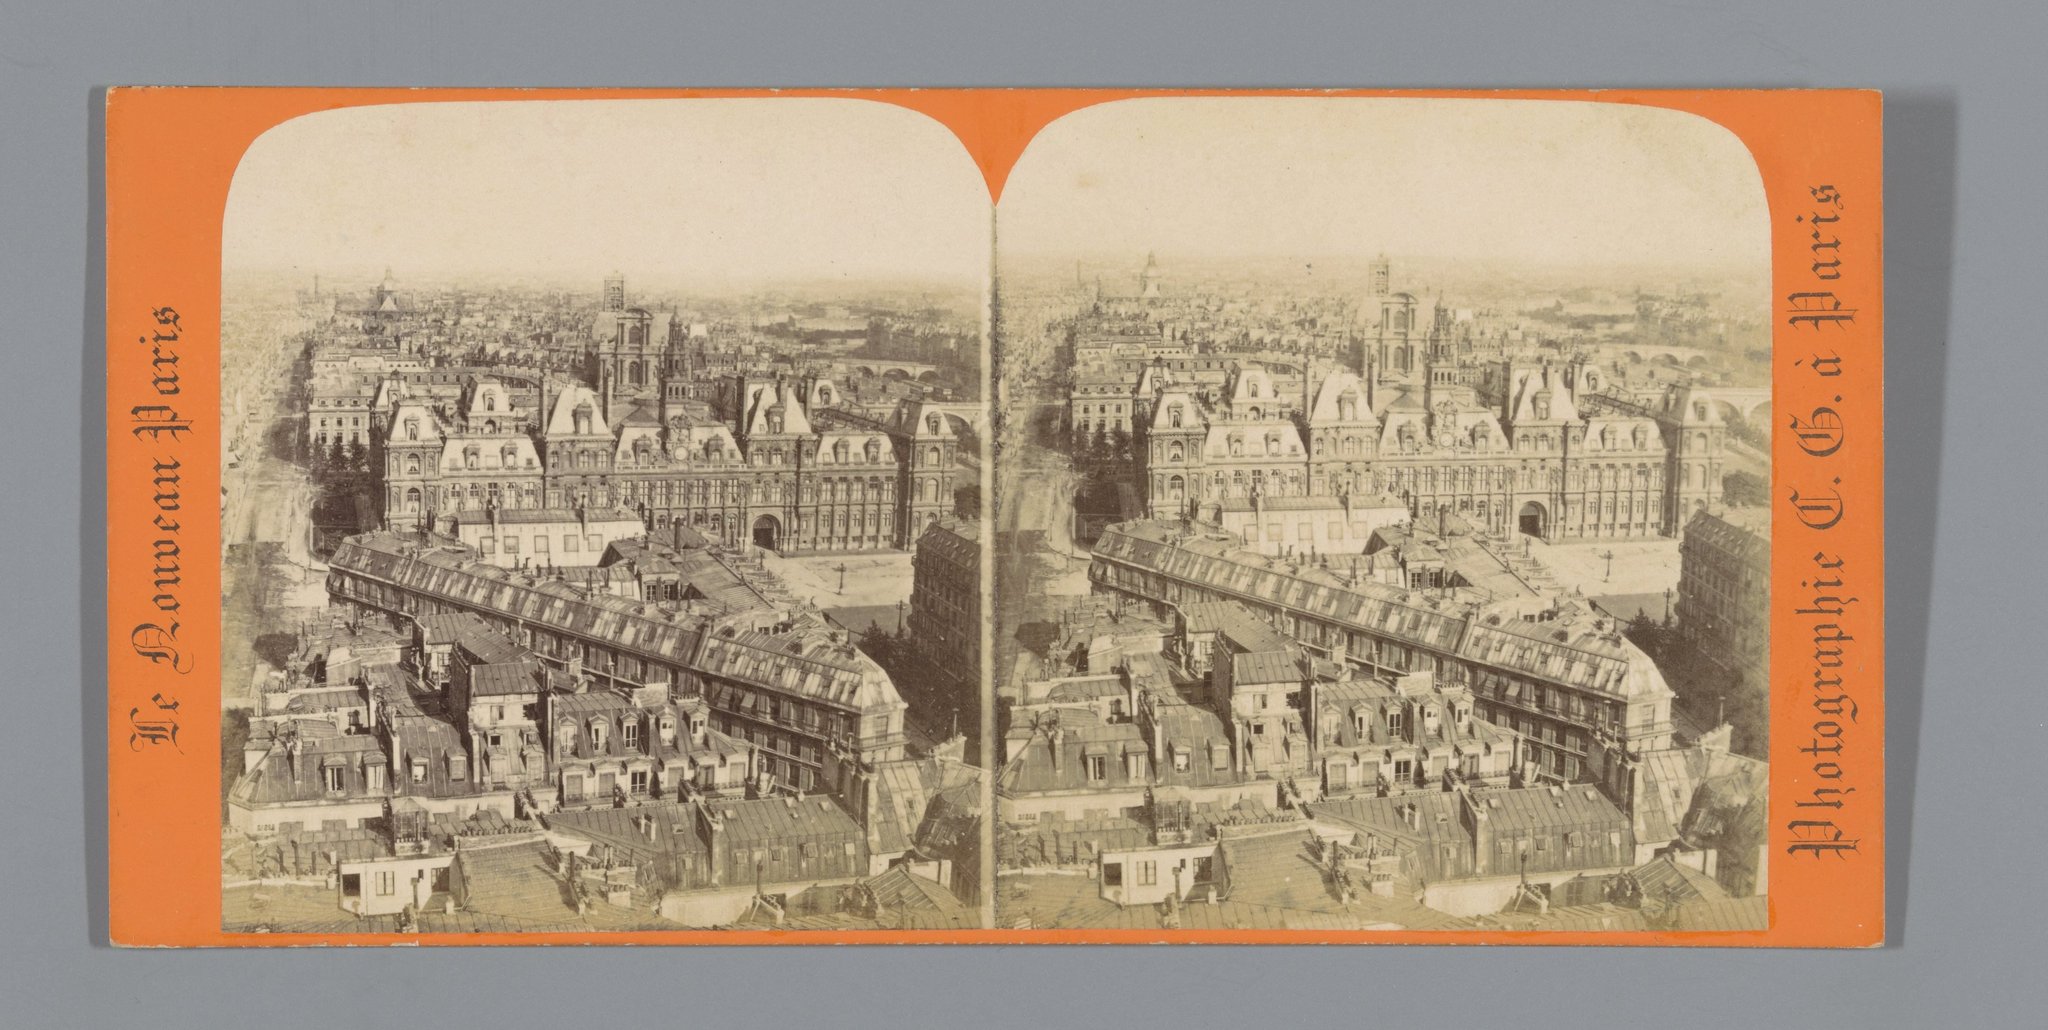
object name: stereograph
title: Gezicht op Parijs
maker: charles gérard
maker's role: fotograaf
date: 1860-1870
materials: cardboard, photographic support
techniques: albumen print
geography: paris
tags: city-view in general; 'veduta', paris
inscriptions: inscription: ‘Panorama de Paris’, inscription: ‘Photographie C. G. à Paris.’